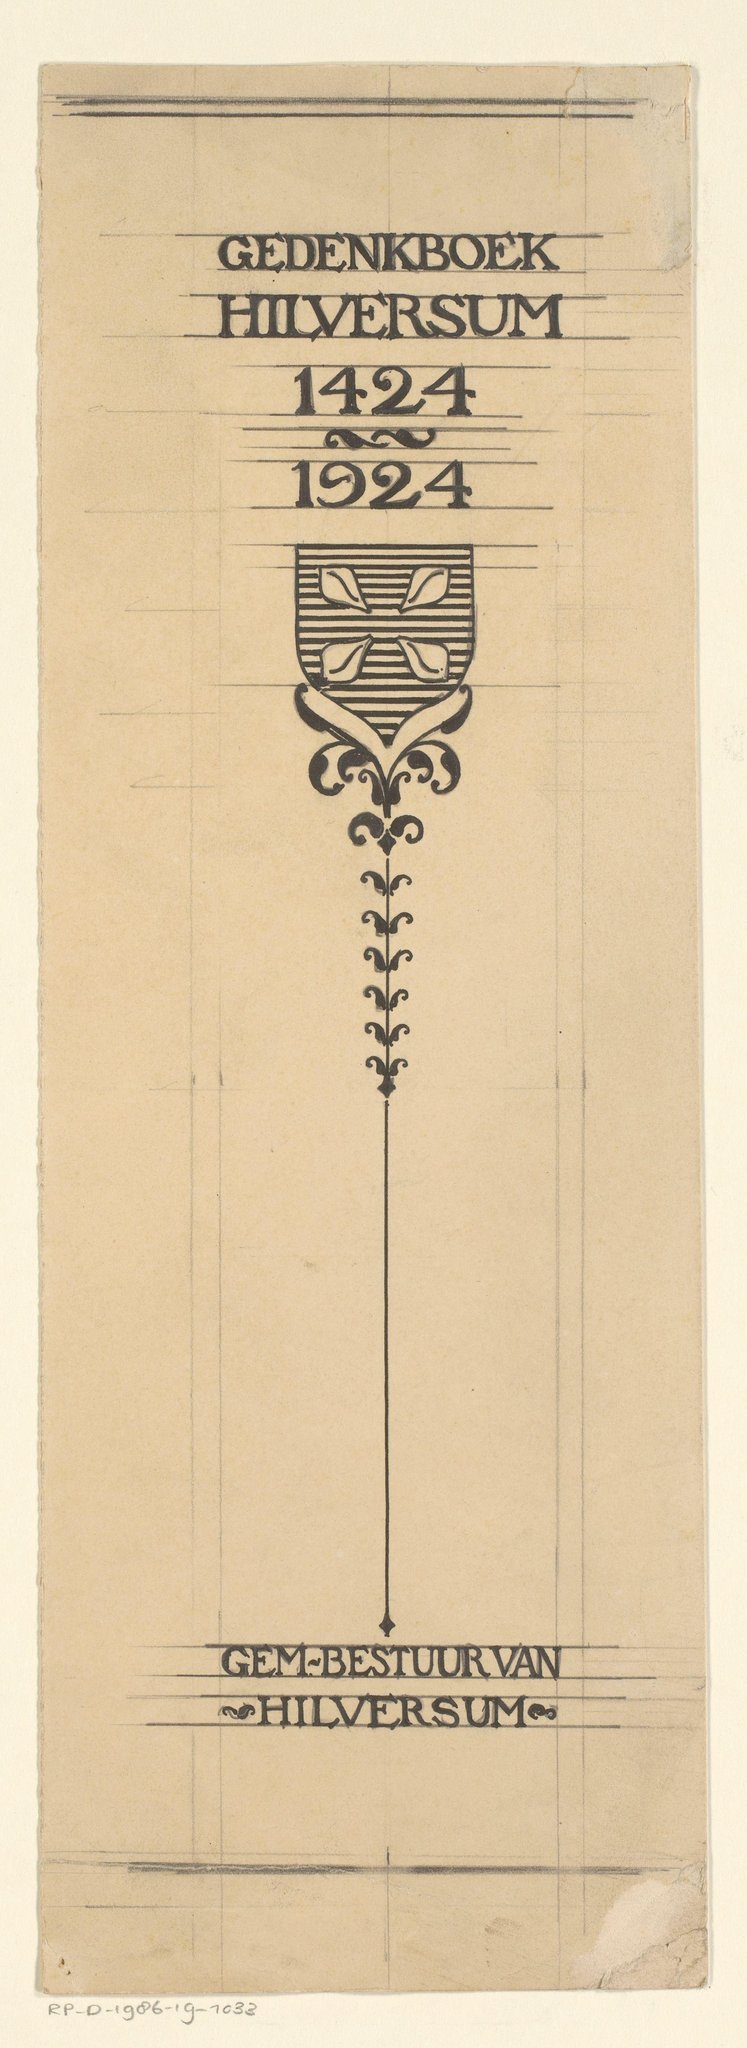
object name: drawing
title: Ontwerp voor een boekrug voor: P.J. Ravesteijn, Gedenkboek Hilversum 1424-1924, 1924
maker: reinier willem petrus de vries (1874-1953)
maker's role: draughtsman, print maker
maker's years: 1874-1953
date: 1924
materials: ink, paper, pencil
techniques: pen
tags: coat of arms (as symbol of the state, etc.) (+ city; municipal), foliage, tendrils, branches ~ ornament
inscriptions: collector's mark: ‘R:MVS.’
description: Ontwerp voor: Ravesteijn, P.J. Gedenkboek Hilversum 1424-1924. Hilversum: Gemeente Hilversum, 1924.